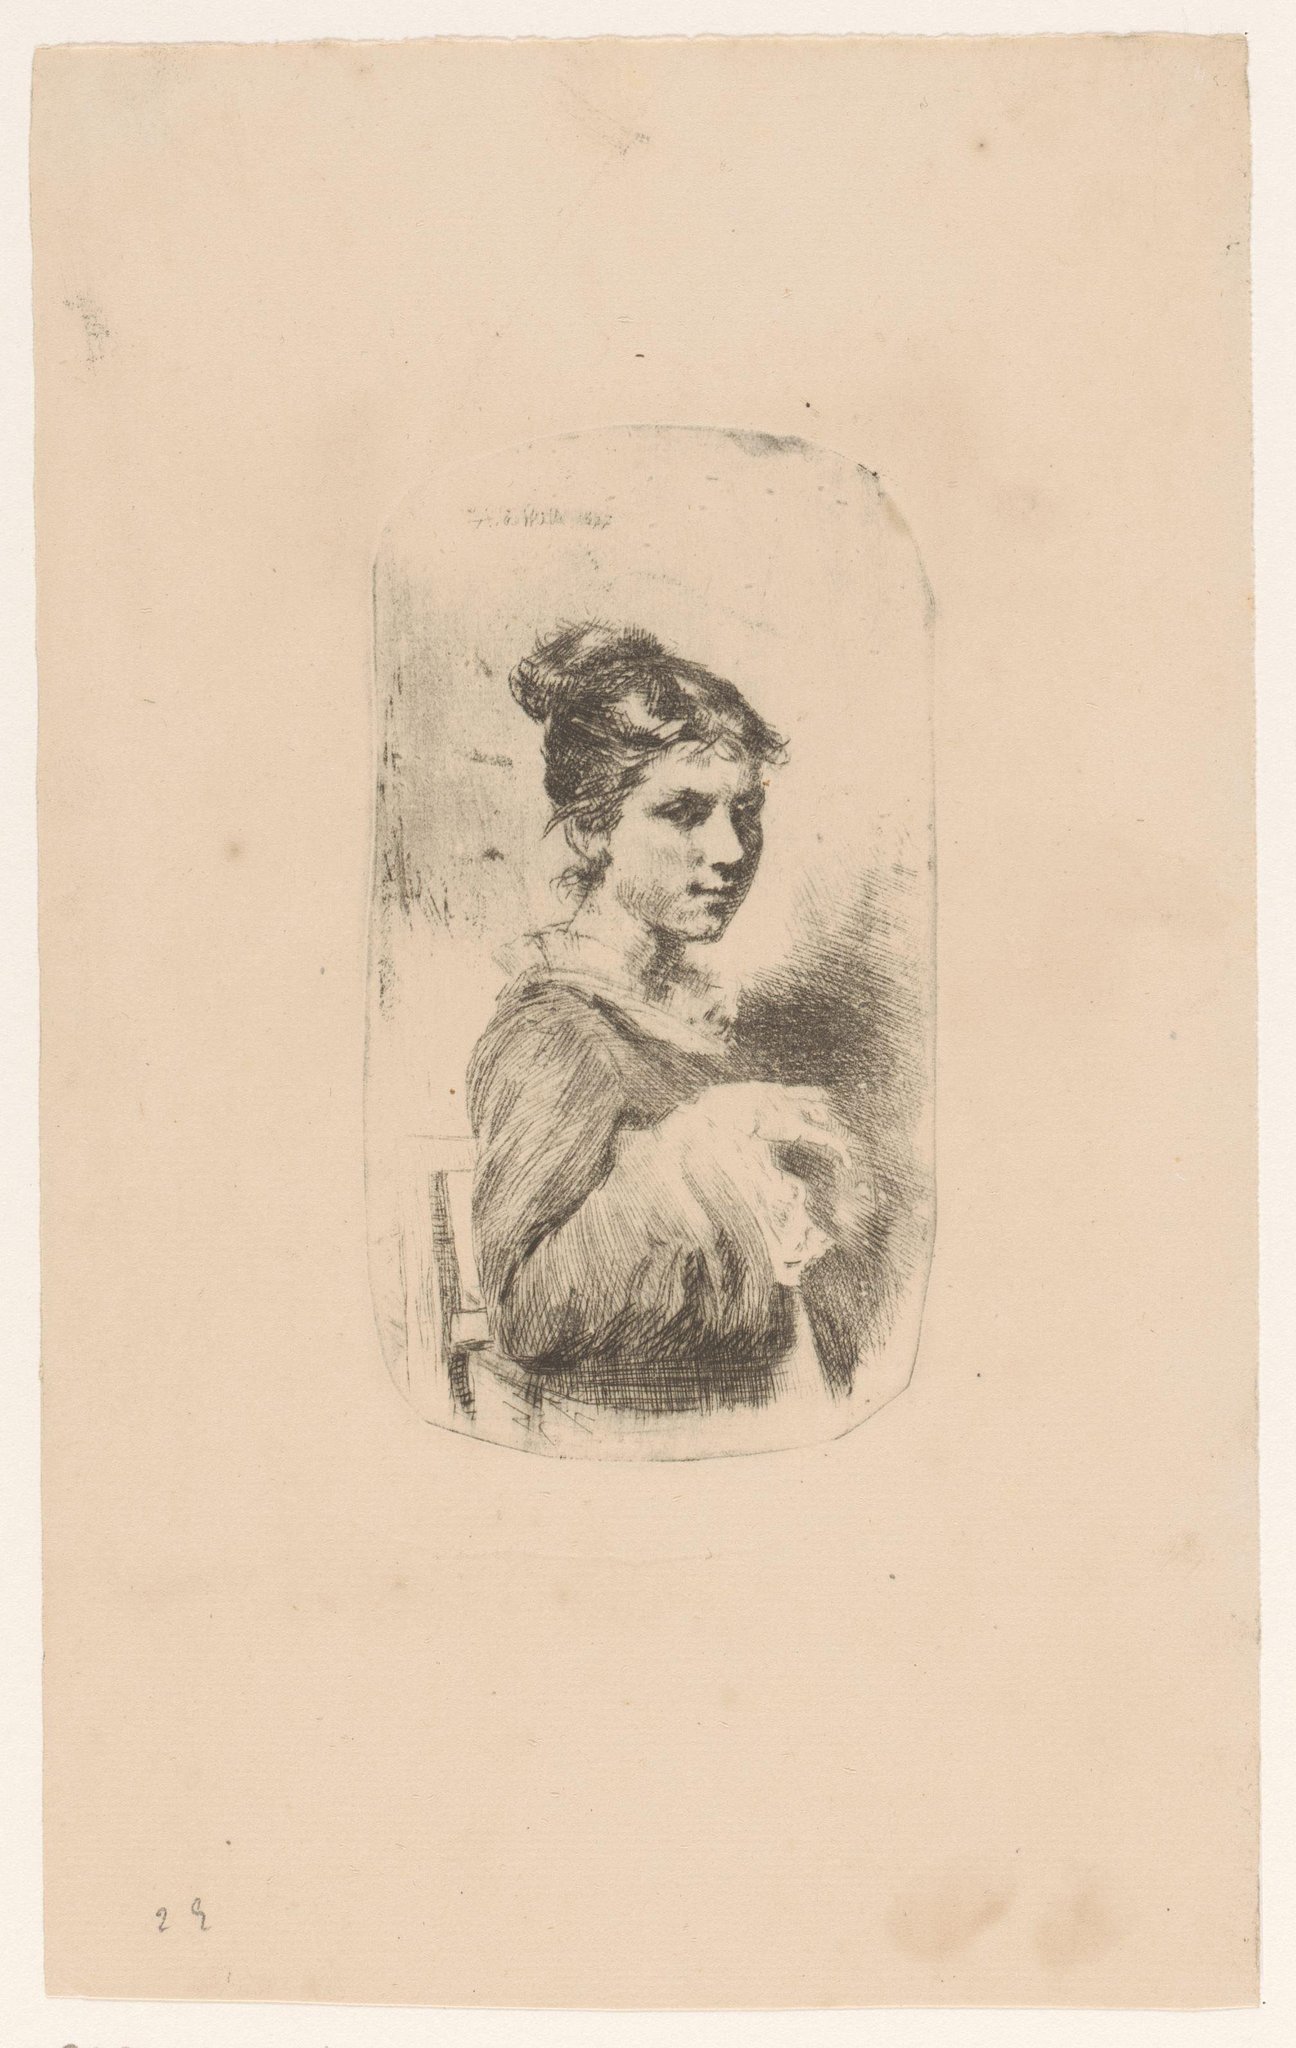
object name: print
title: Onbekende jonge vrouw gezeten op een stoel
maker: adrien de witte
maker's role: print maker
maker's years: 1850-1935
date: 1877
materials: paper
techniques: etching, intaglio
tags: adolescent, young woman, maiden, historical persons, chair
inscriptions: collector's mark: Lugt 2228